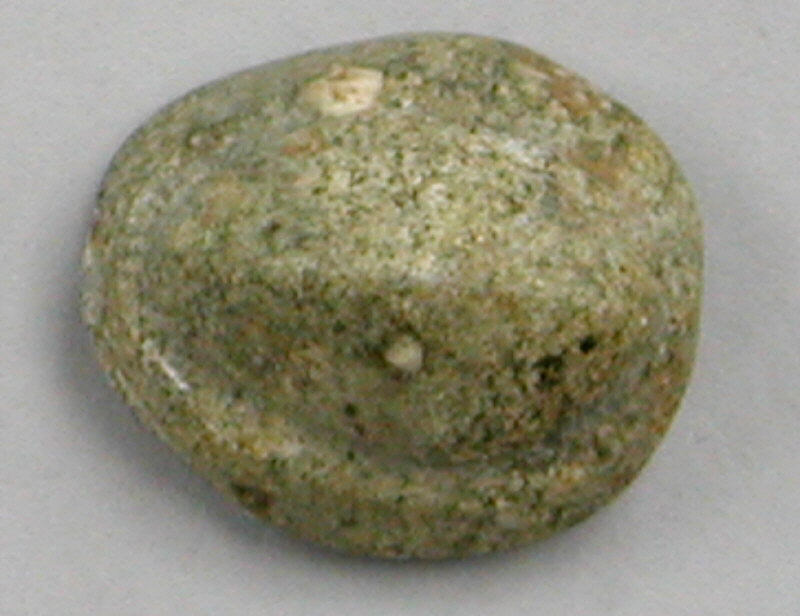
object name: pendant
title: Stone Turtle Pendant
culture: mexican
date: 1501-1600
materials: stone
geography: mexico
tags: turtles